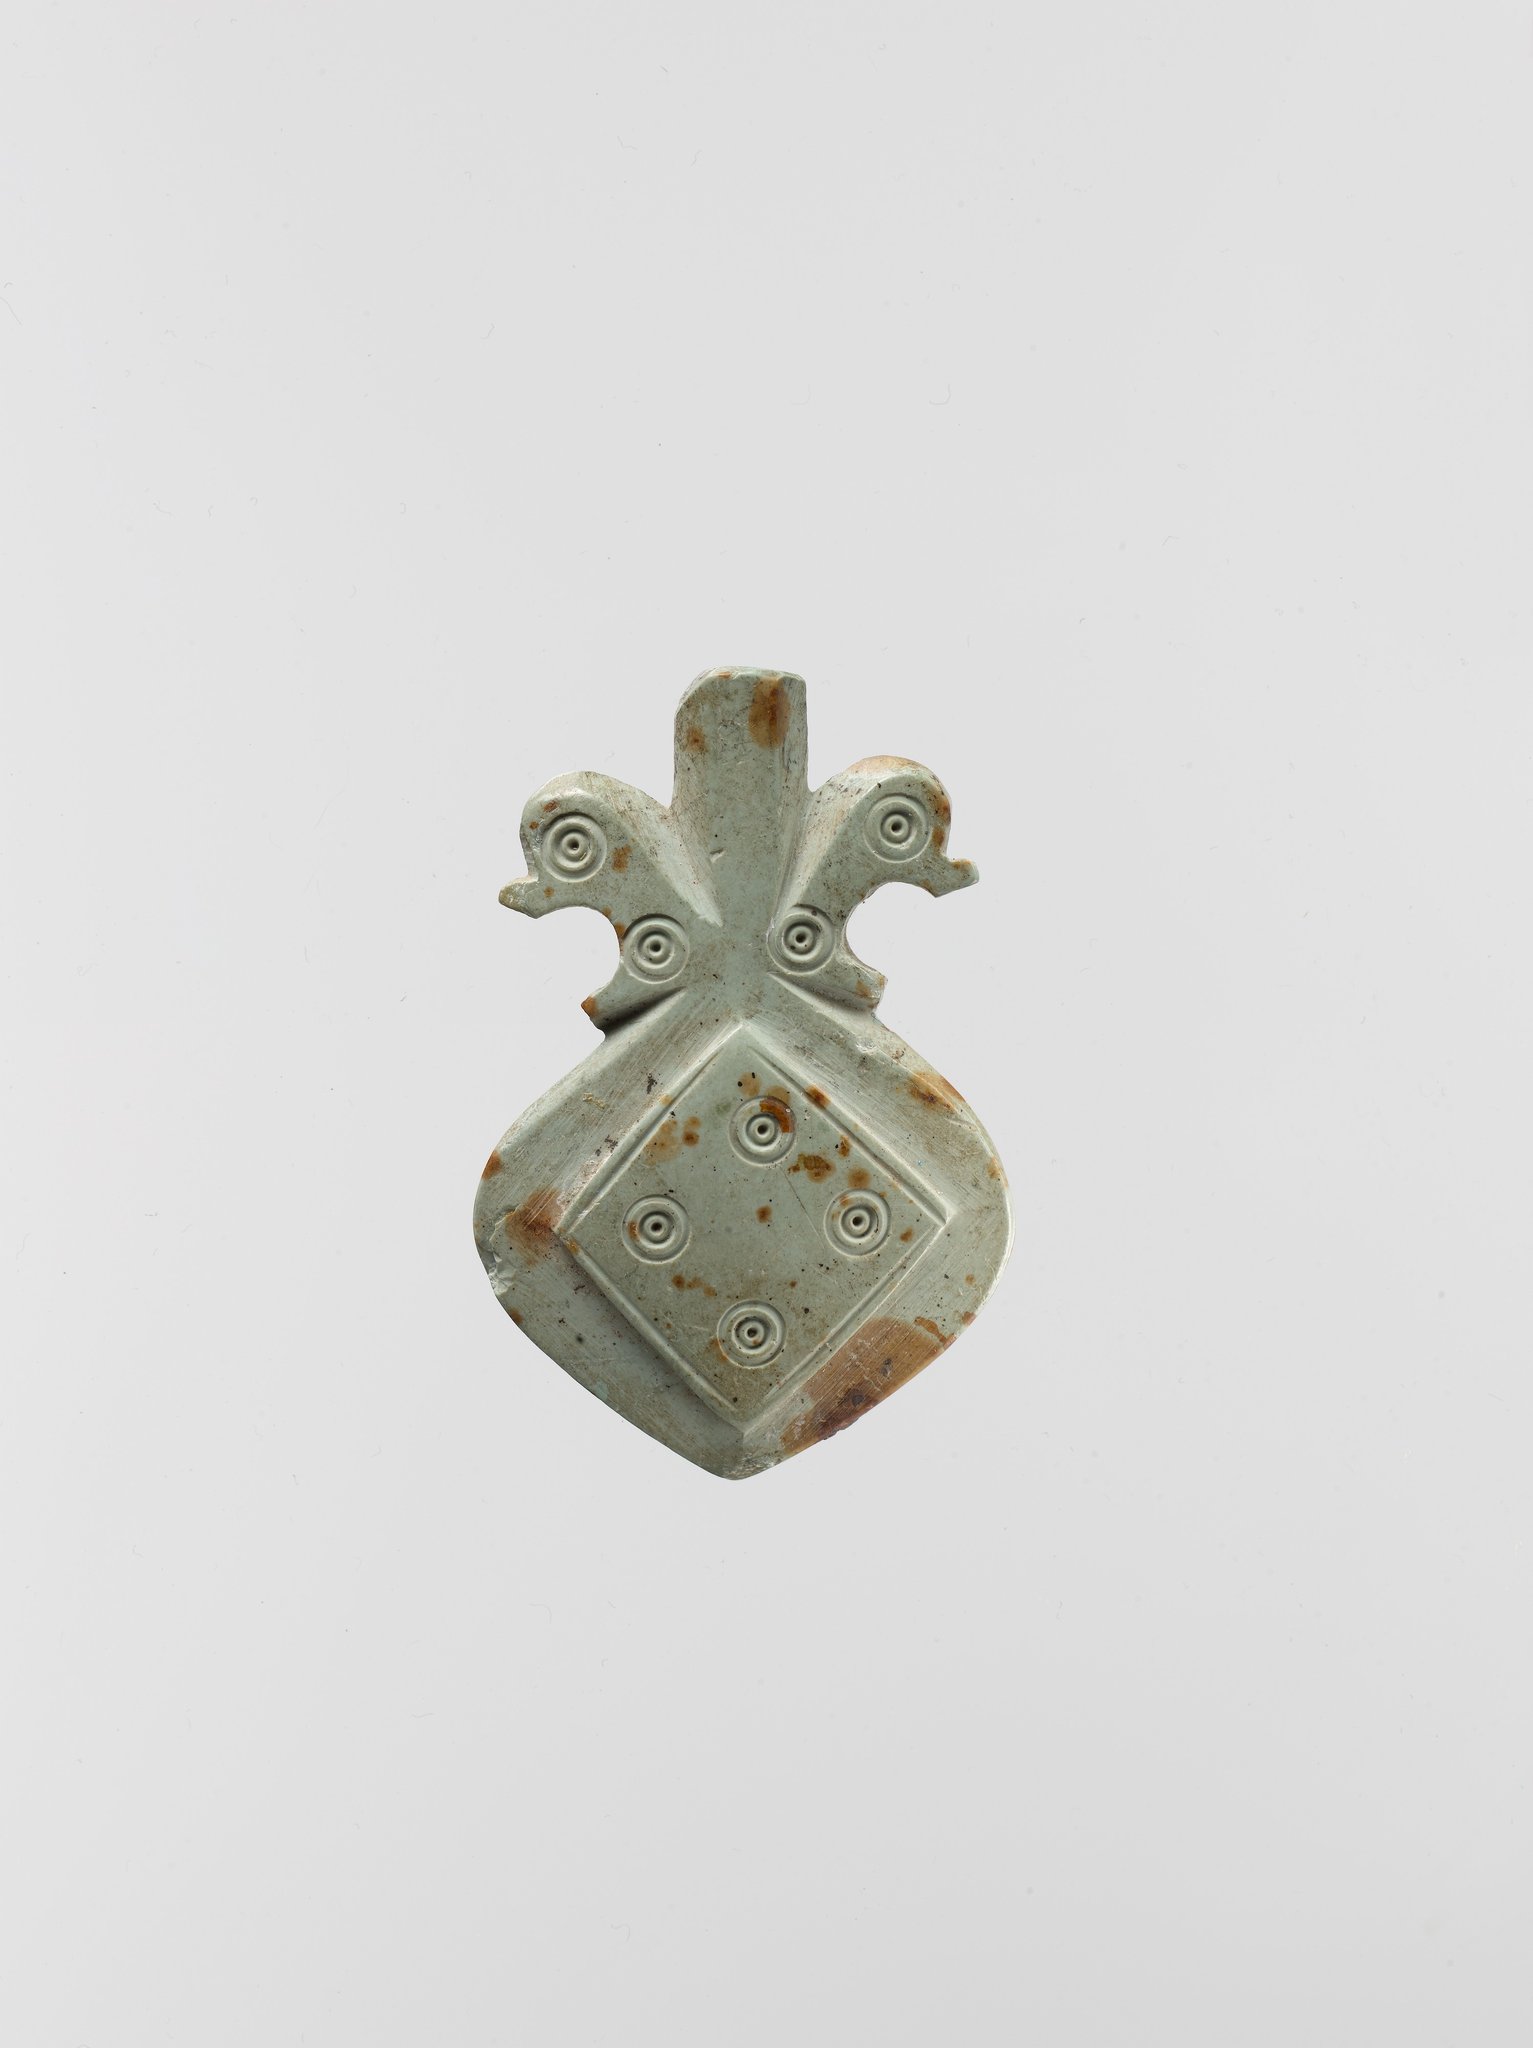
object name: kohl flask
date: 901-1200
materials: stone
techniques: carving, incising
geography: iran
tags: birds